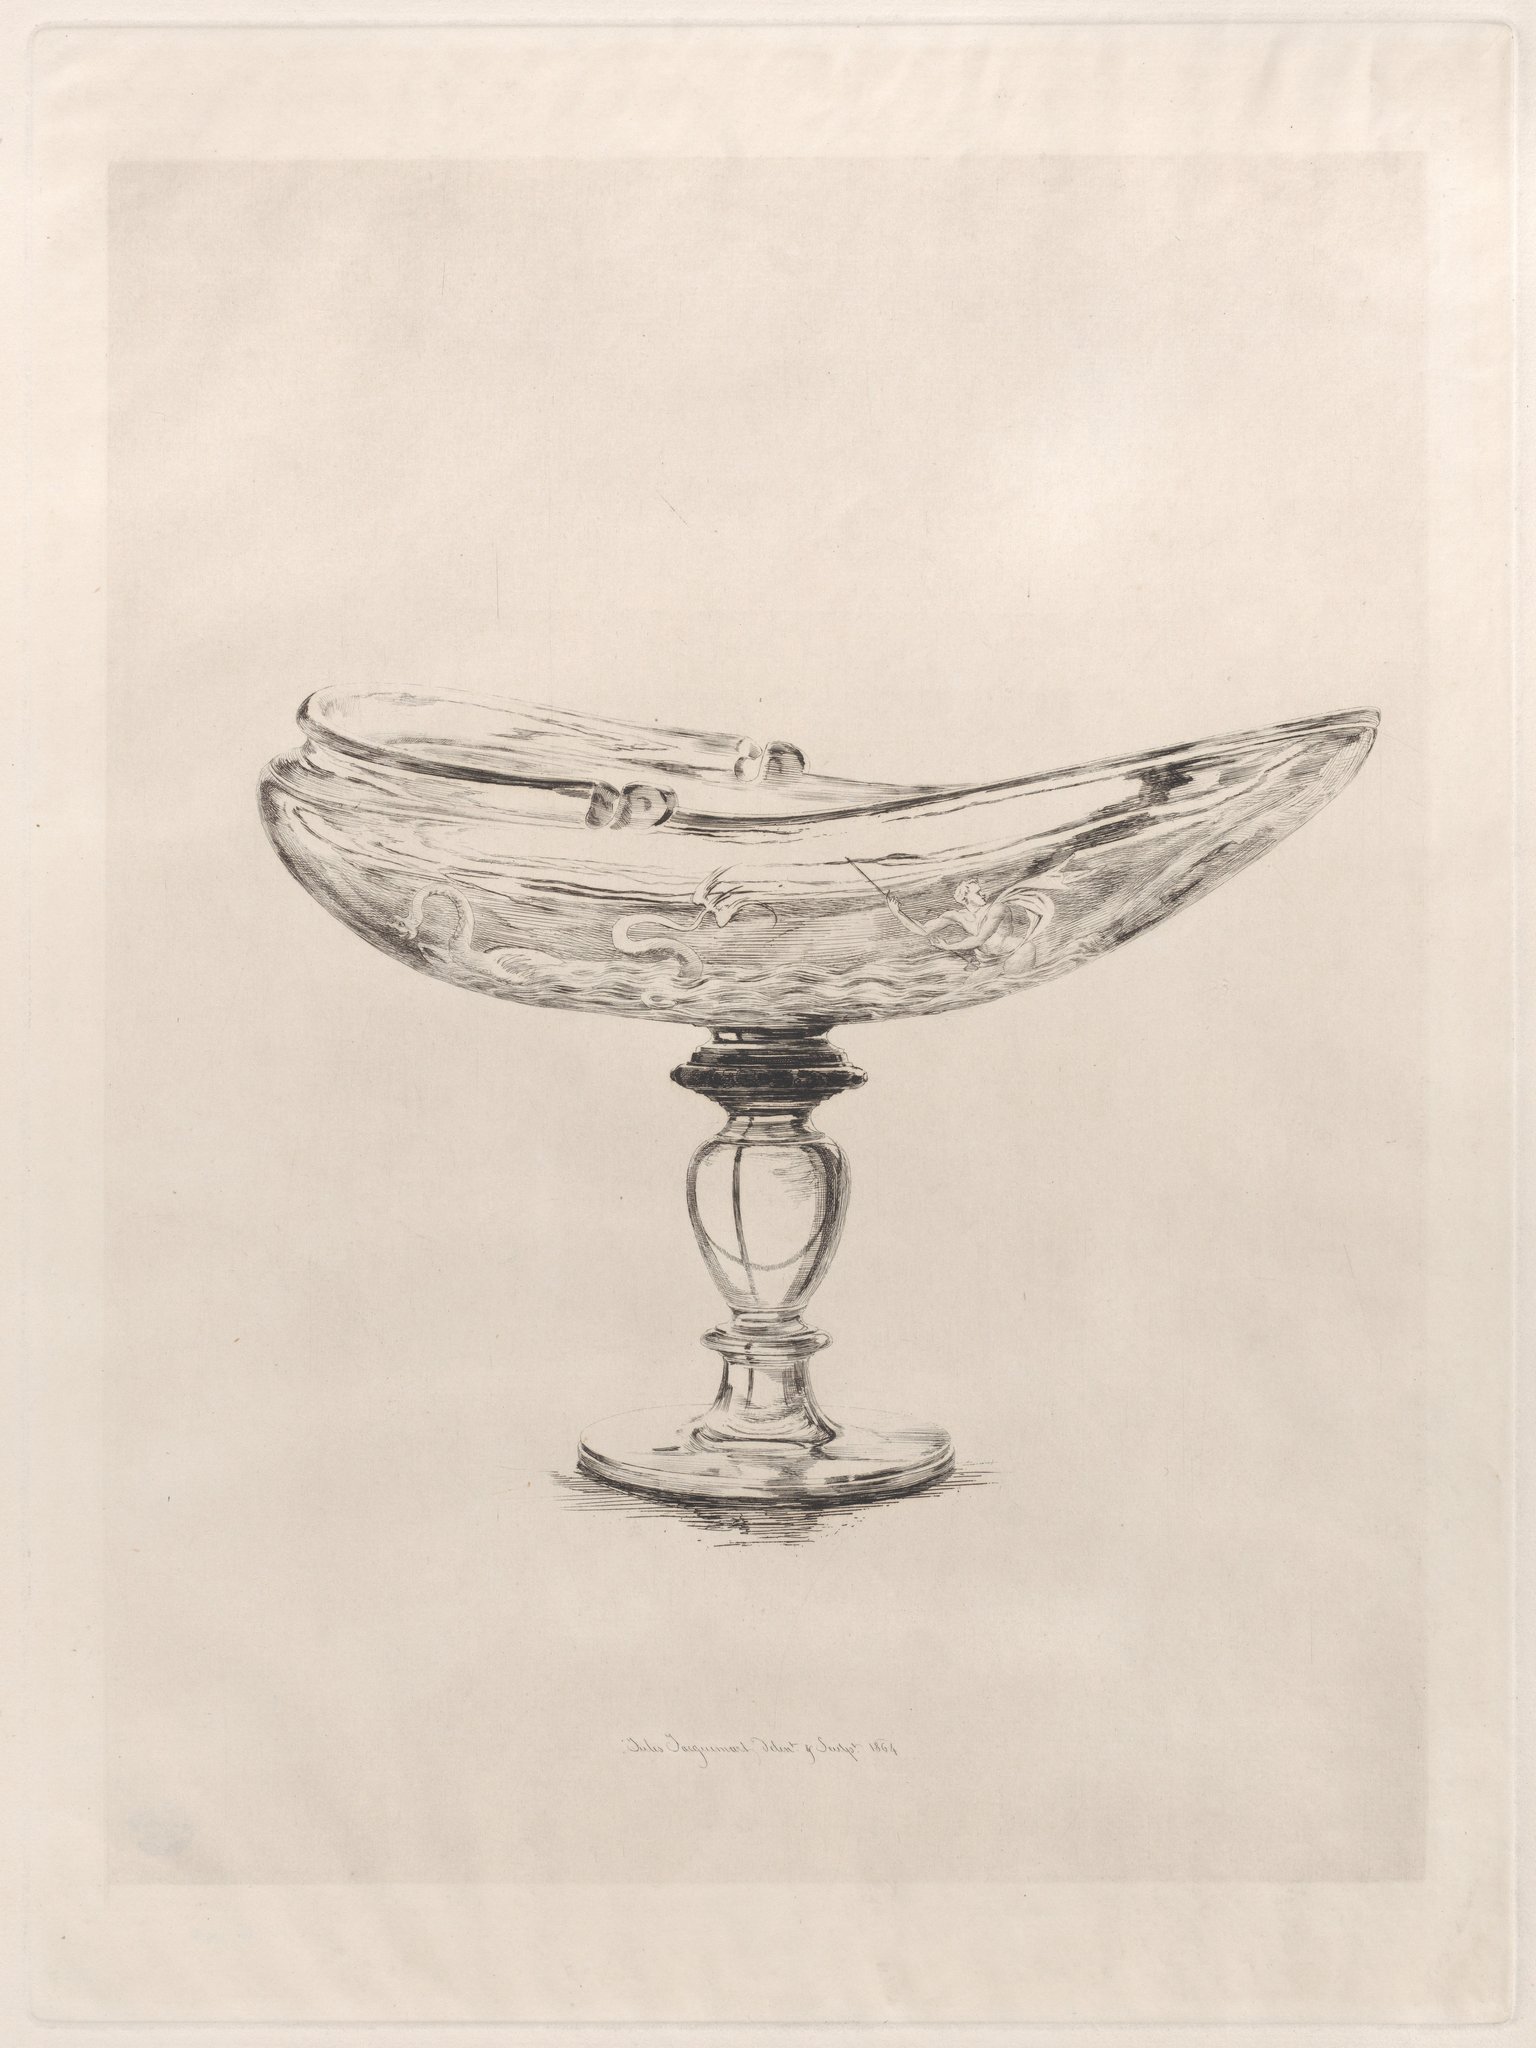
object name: print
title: Crystal Bezel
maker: jules-ferdinand jacquemart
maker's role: artist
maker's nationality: french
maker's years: 1837-1880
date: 1864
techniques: etching